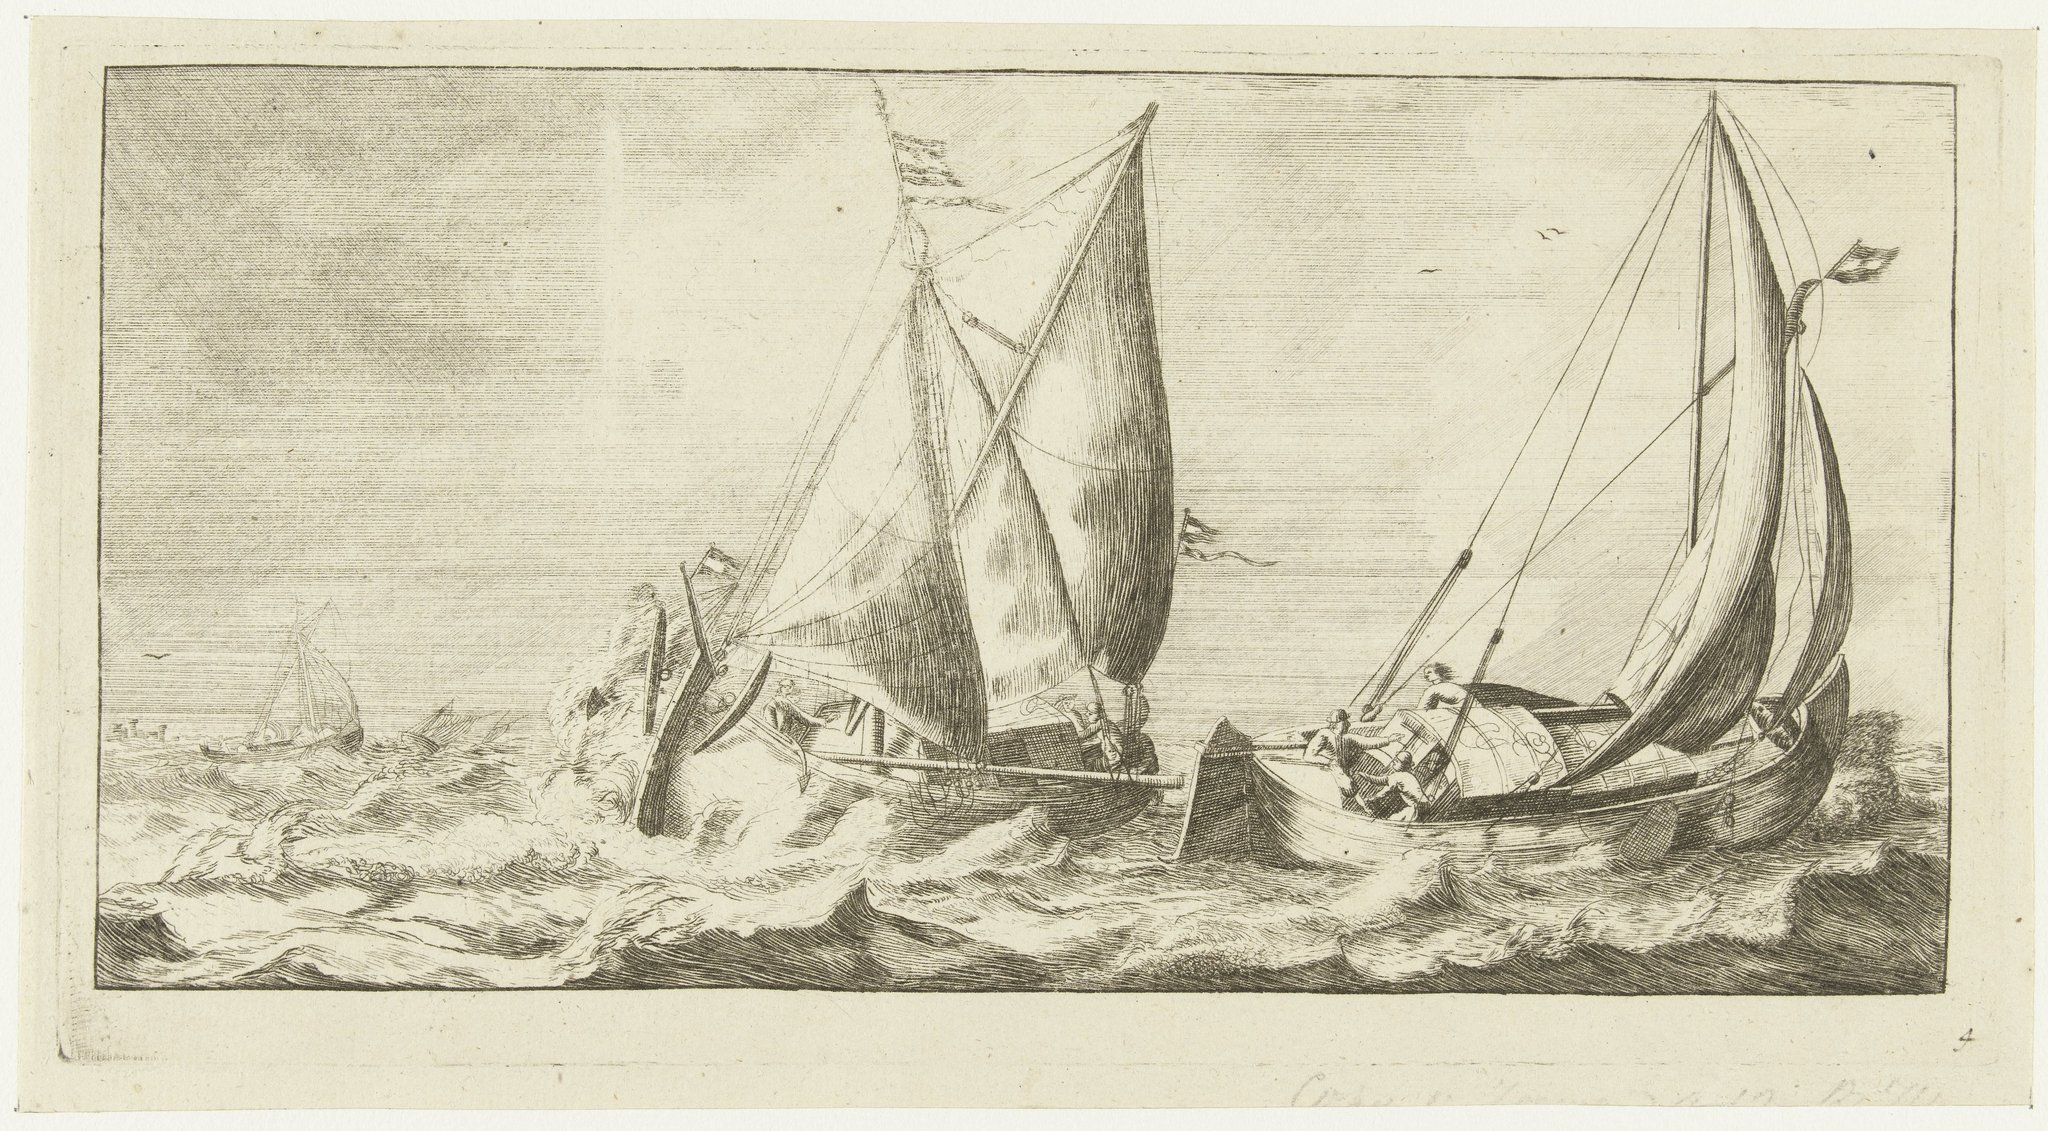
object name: print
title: Zeegezichten en afbeeldingen van schepen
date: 1730-1760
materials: paper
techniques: etching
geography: netherlands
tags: sailing-ship, sailing-boat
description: Kopie in spiegelbeeld. Schepen op een ruige zee. Rechts een ijzeren varken, een aan de Overijsselse pot verwant scheepstype, en links een waterschip, ook wel Zuiderzee vissersboot.